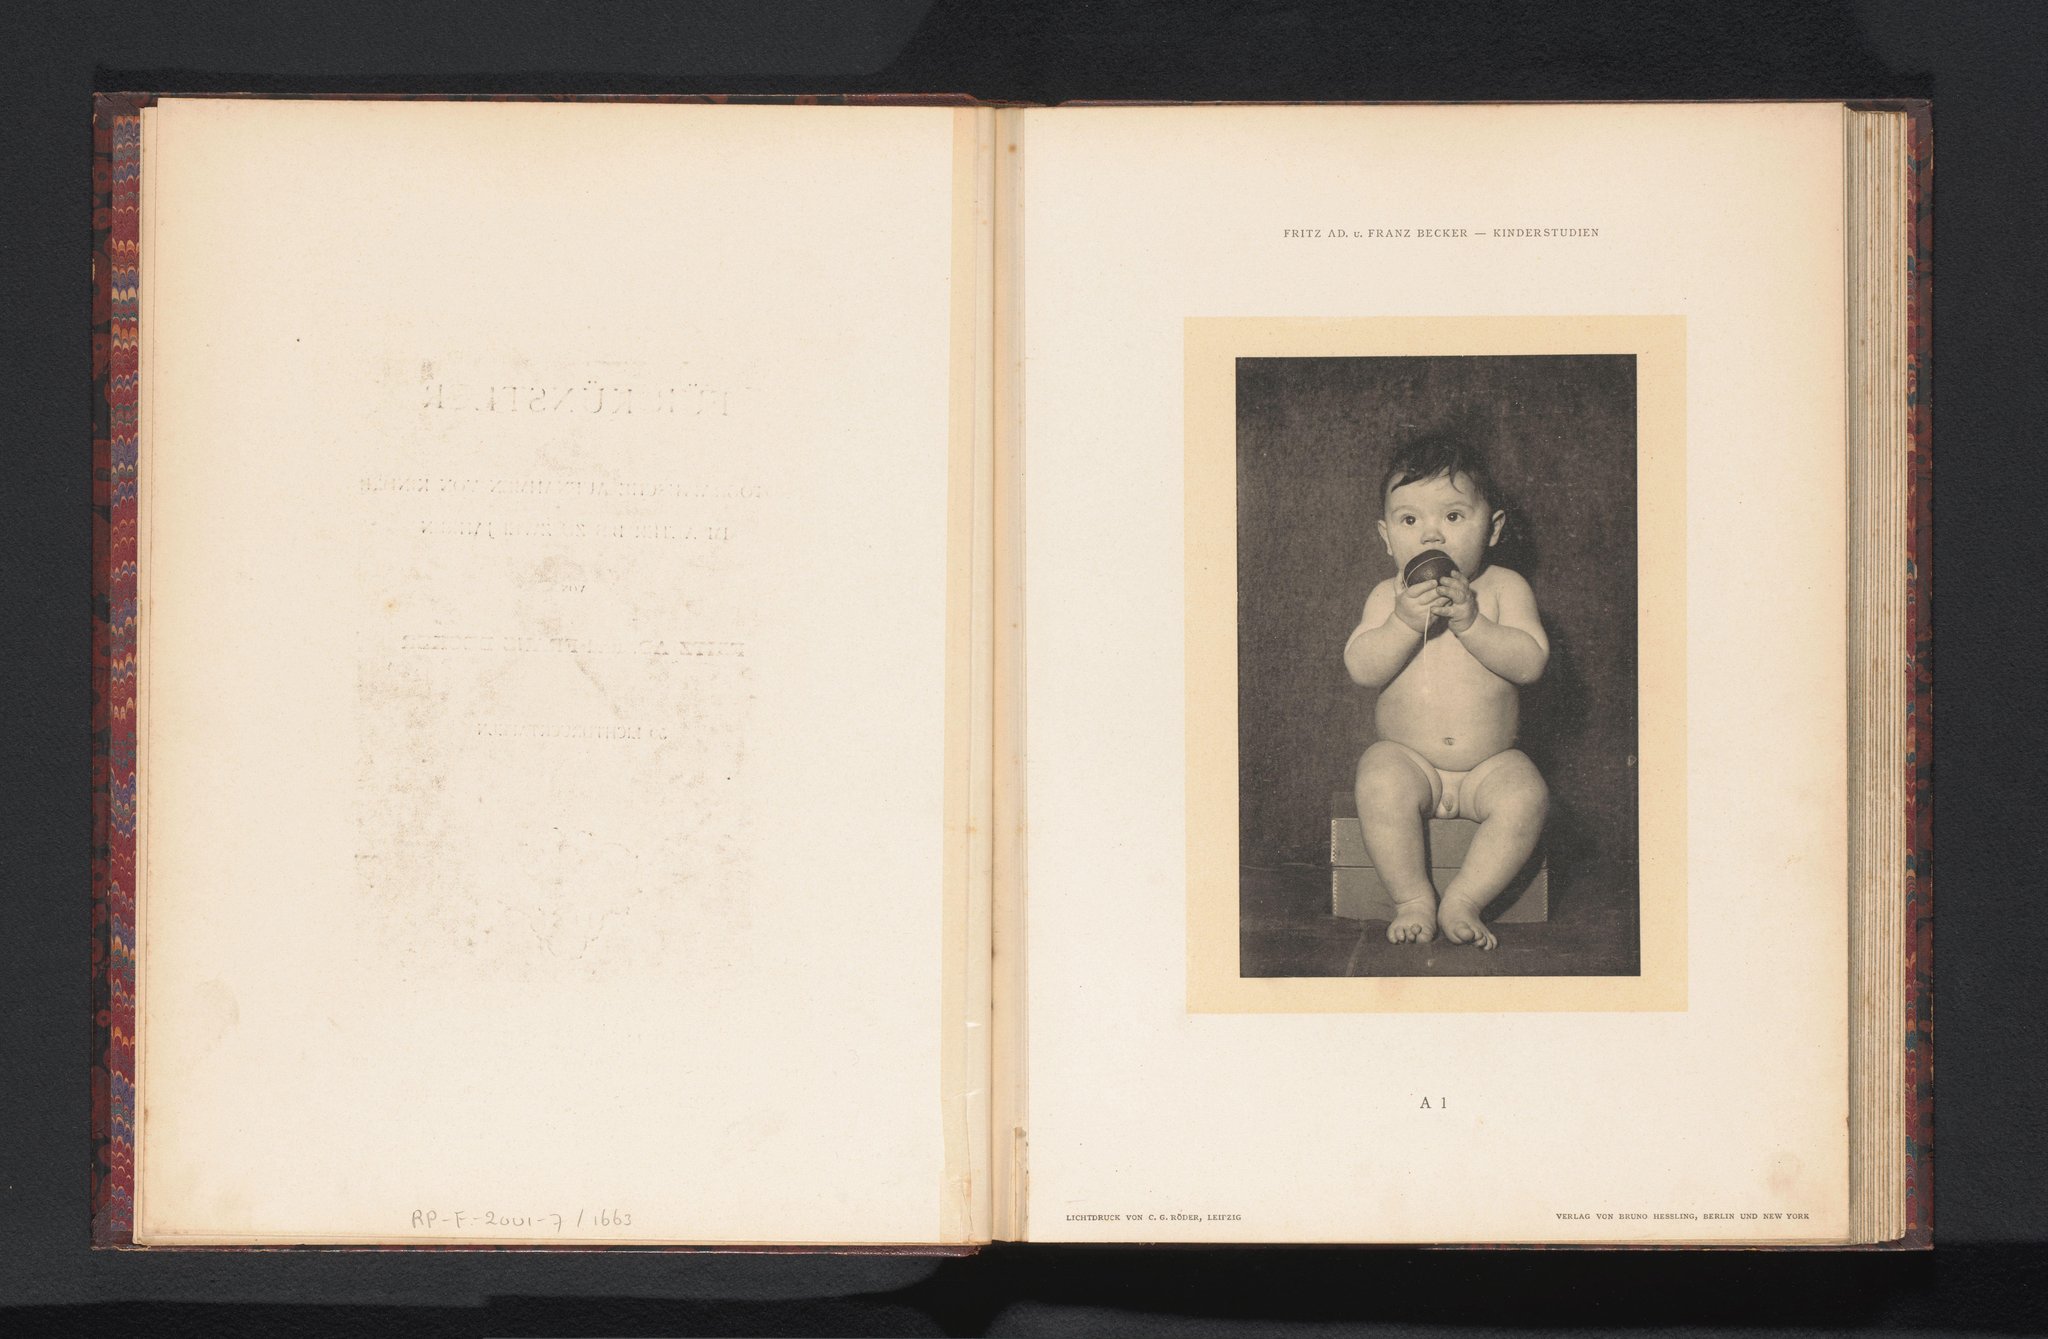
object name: page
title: Zittende naakte jongen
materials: paper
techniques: photograph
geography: berlin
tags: toddler (male), sitting on an elevation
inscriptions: number: ‘A 1’